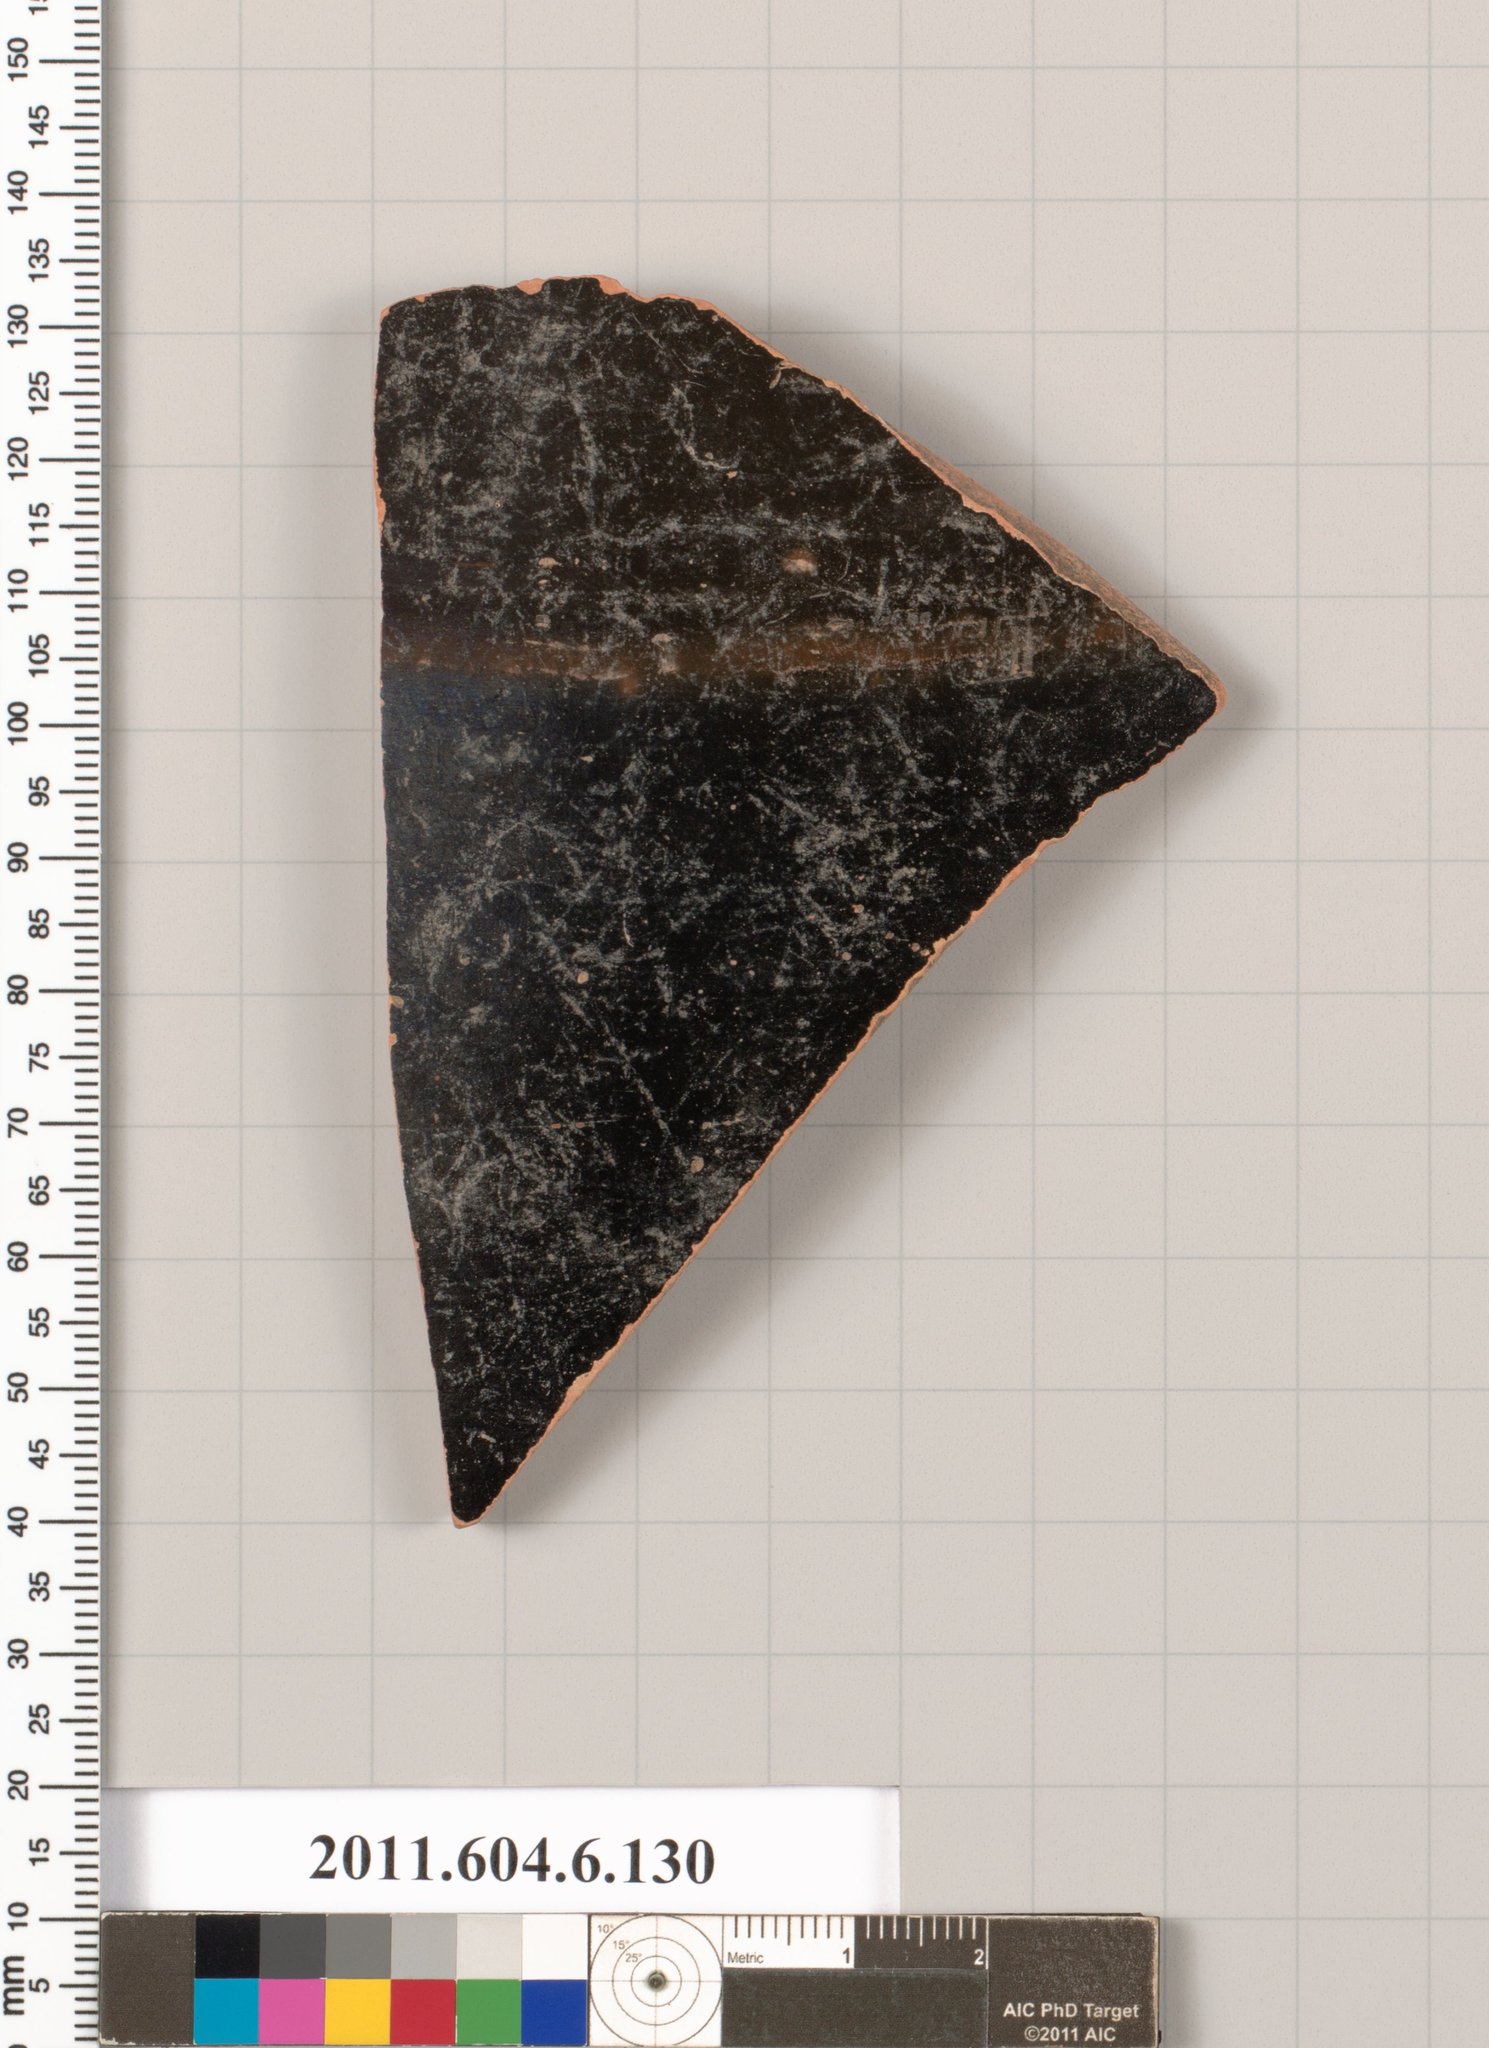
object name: undetermined open shape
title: Terracotta fragment of an open shape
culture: greek, attic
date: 600-401 BCE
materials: terracotta